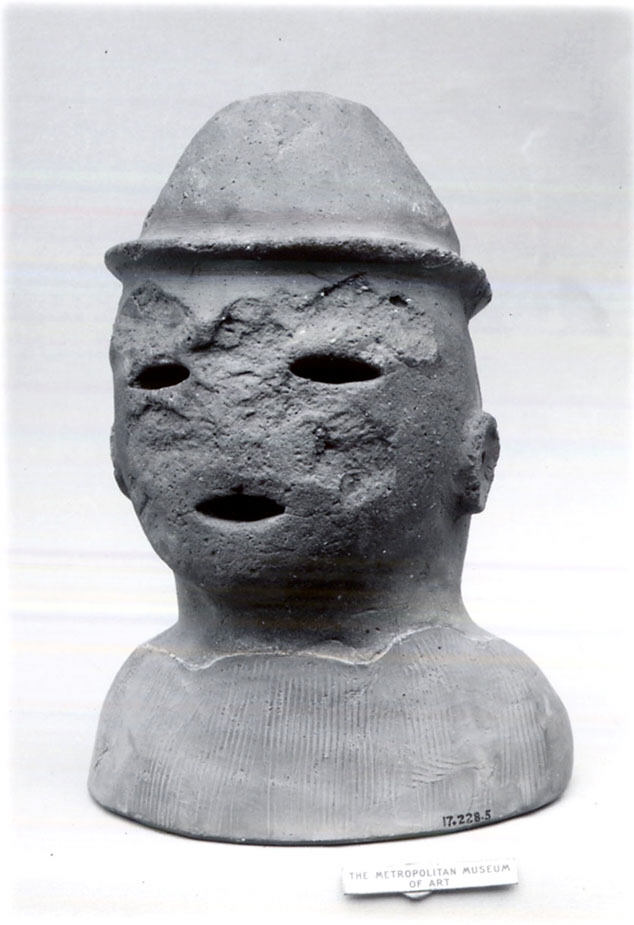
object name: haniwa head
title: Head of a Male Haniwa Figure with Headdress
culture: japanese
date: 401-700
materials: earthenware